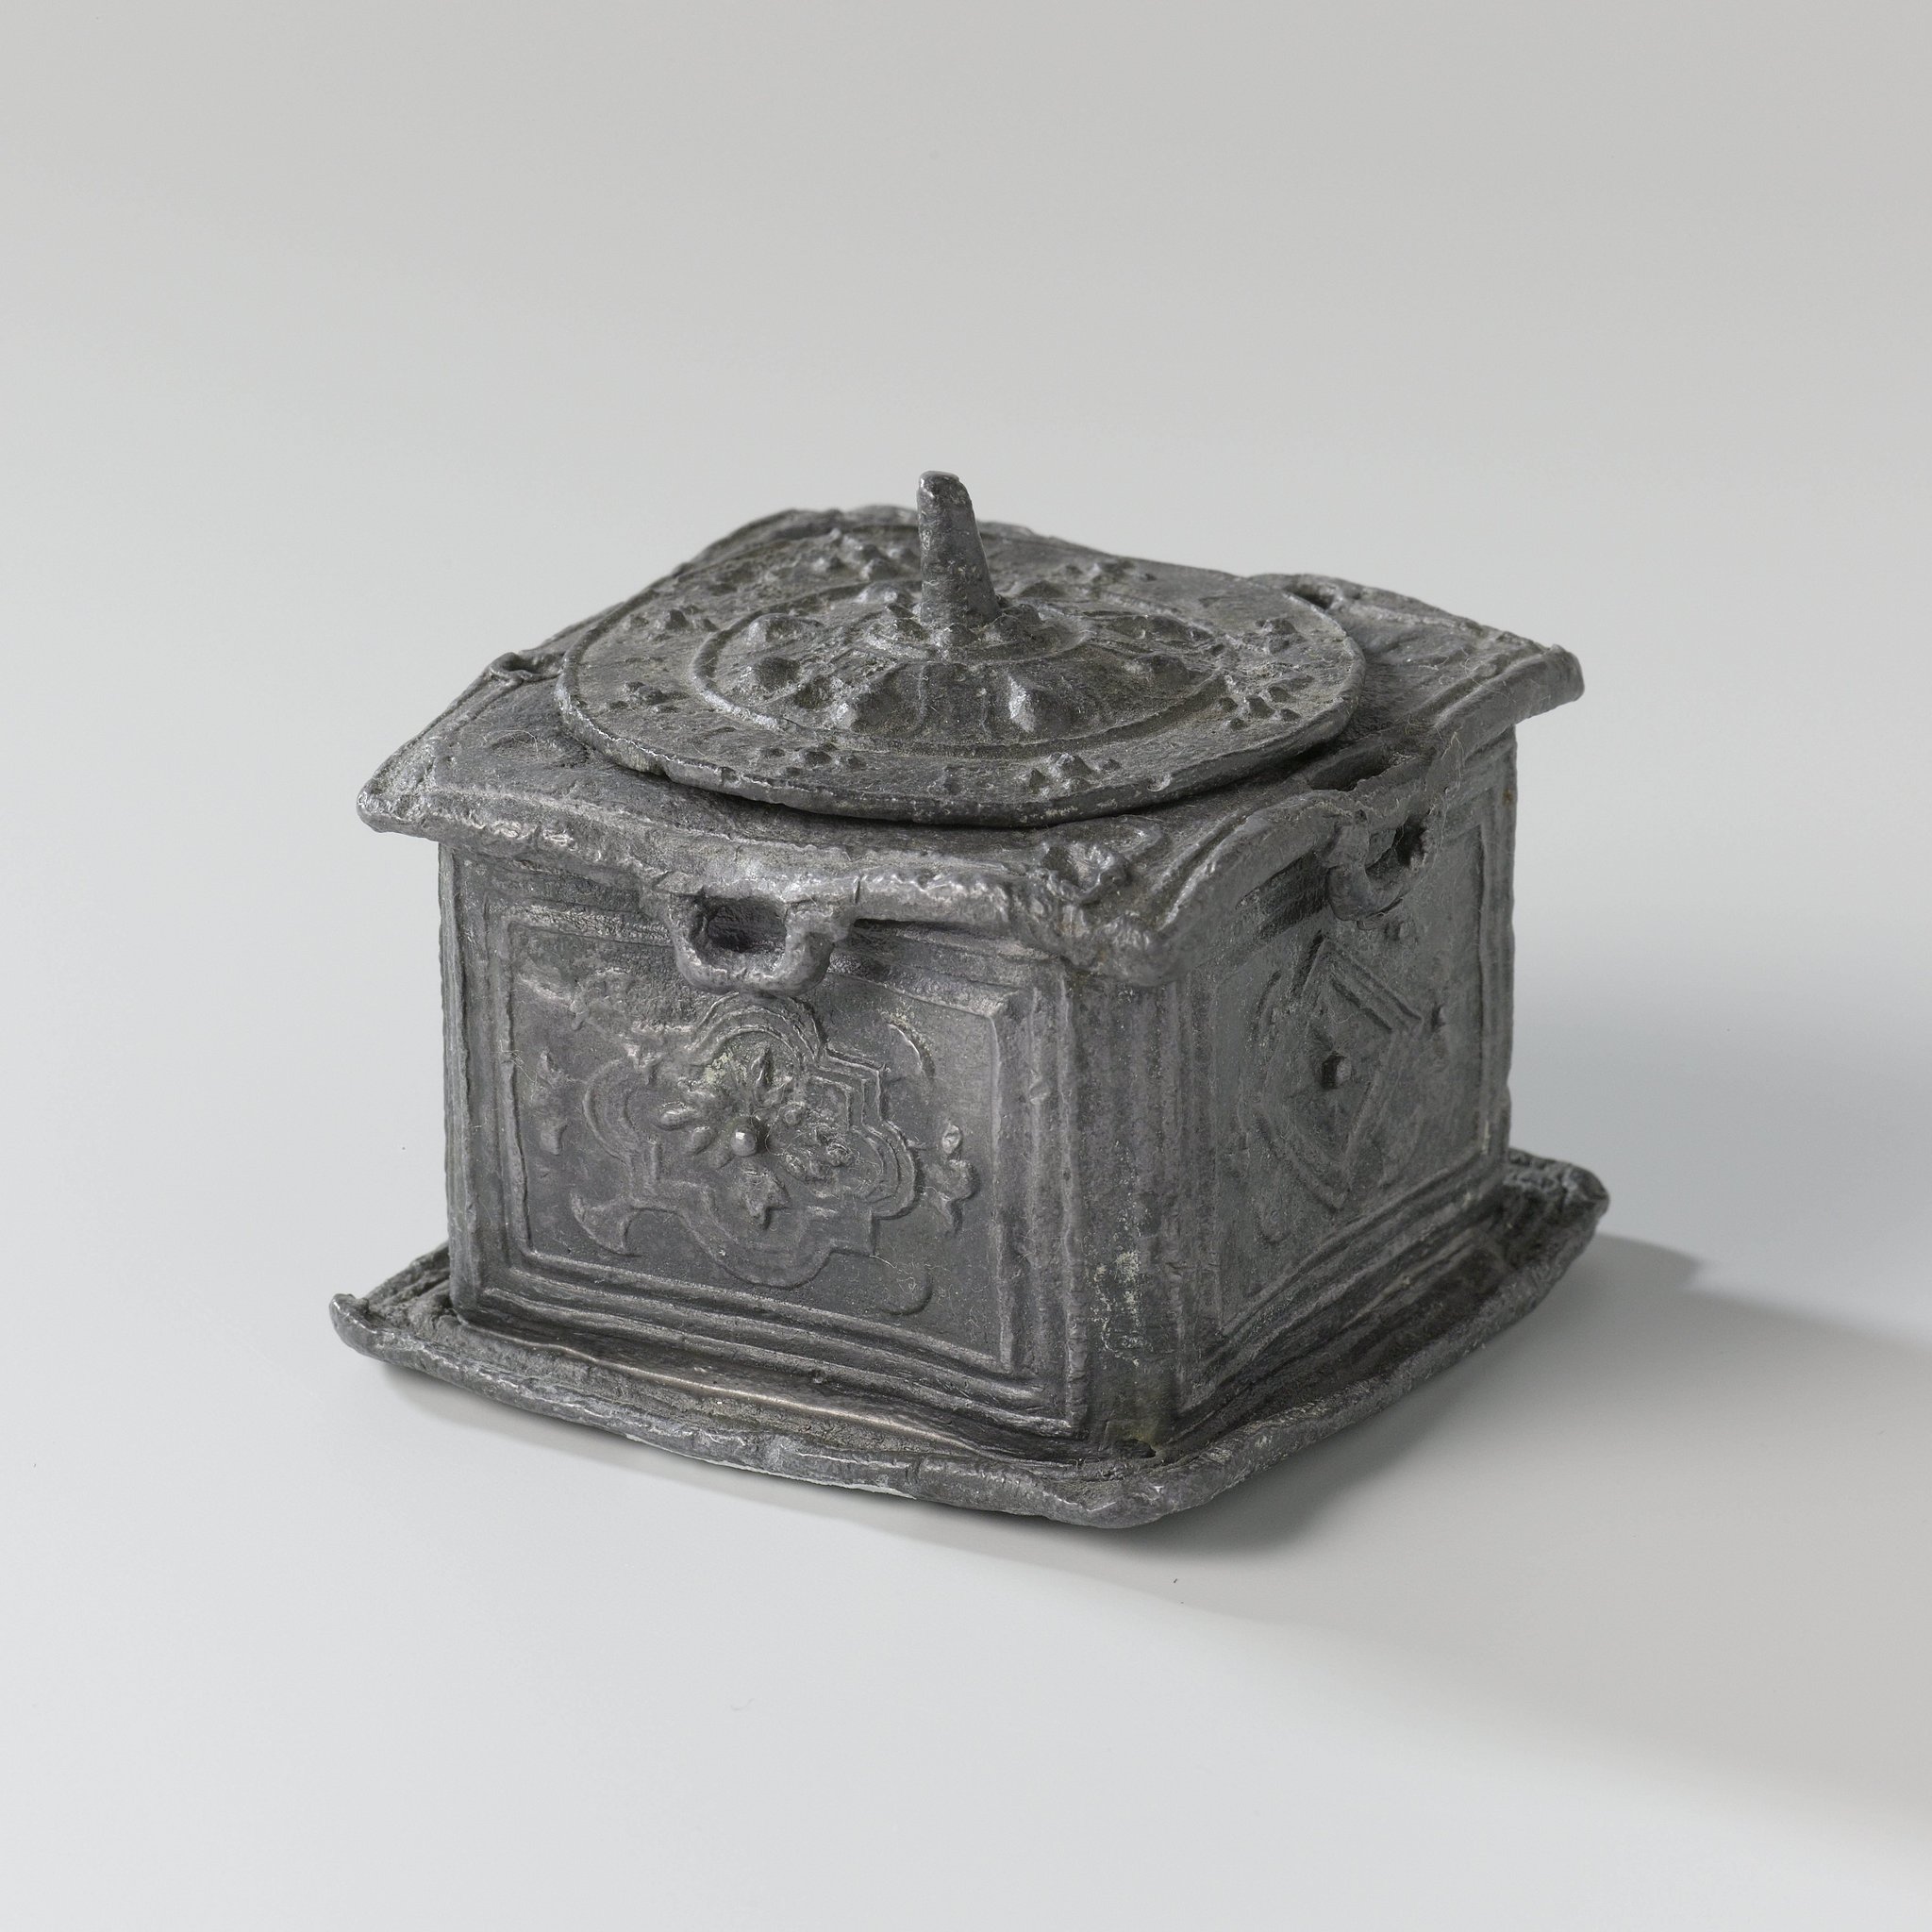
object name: inkwell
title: Navigation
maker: Anonymous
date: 1590-1596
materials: lead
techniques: casting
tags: willem barendsz., amsterdam, jacob van heemskerck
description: To determine the ship’s position and chart its course, the captain had an entire arsenal of instruments at his disposal. Among the items found on Nova Zembla are an astrolabium catholicum (universal astrolabe), a fragment of a copper sounding line, a cross staff, a sextant and a chart compass.